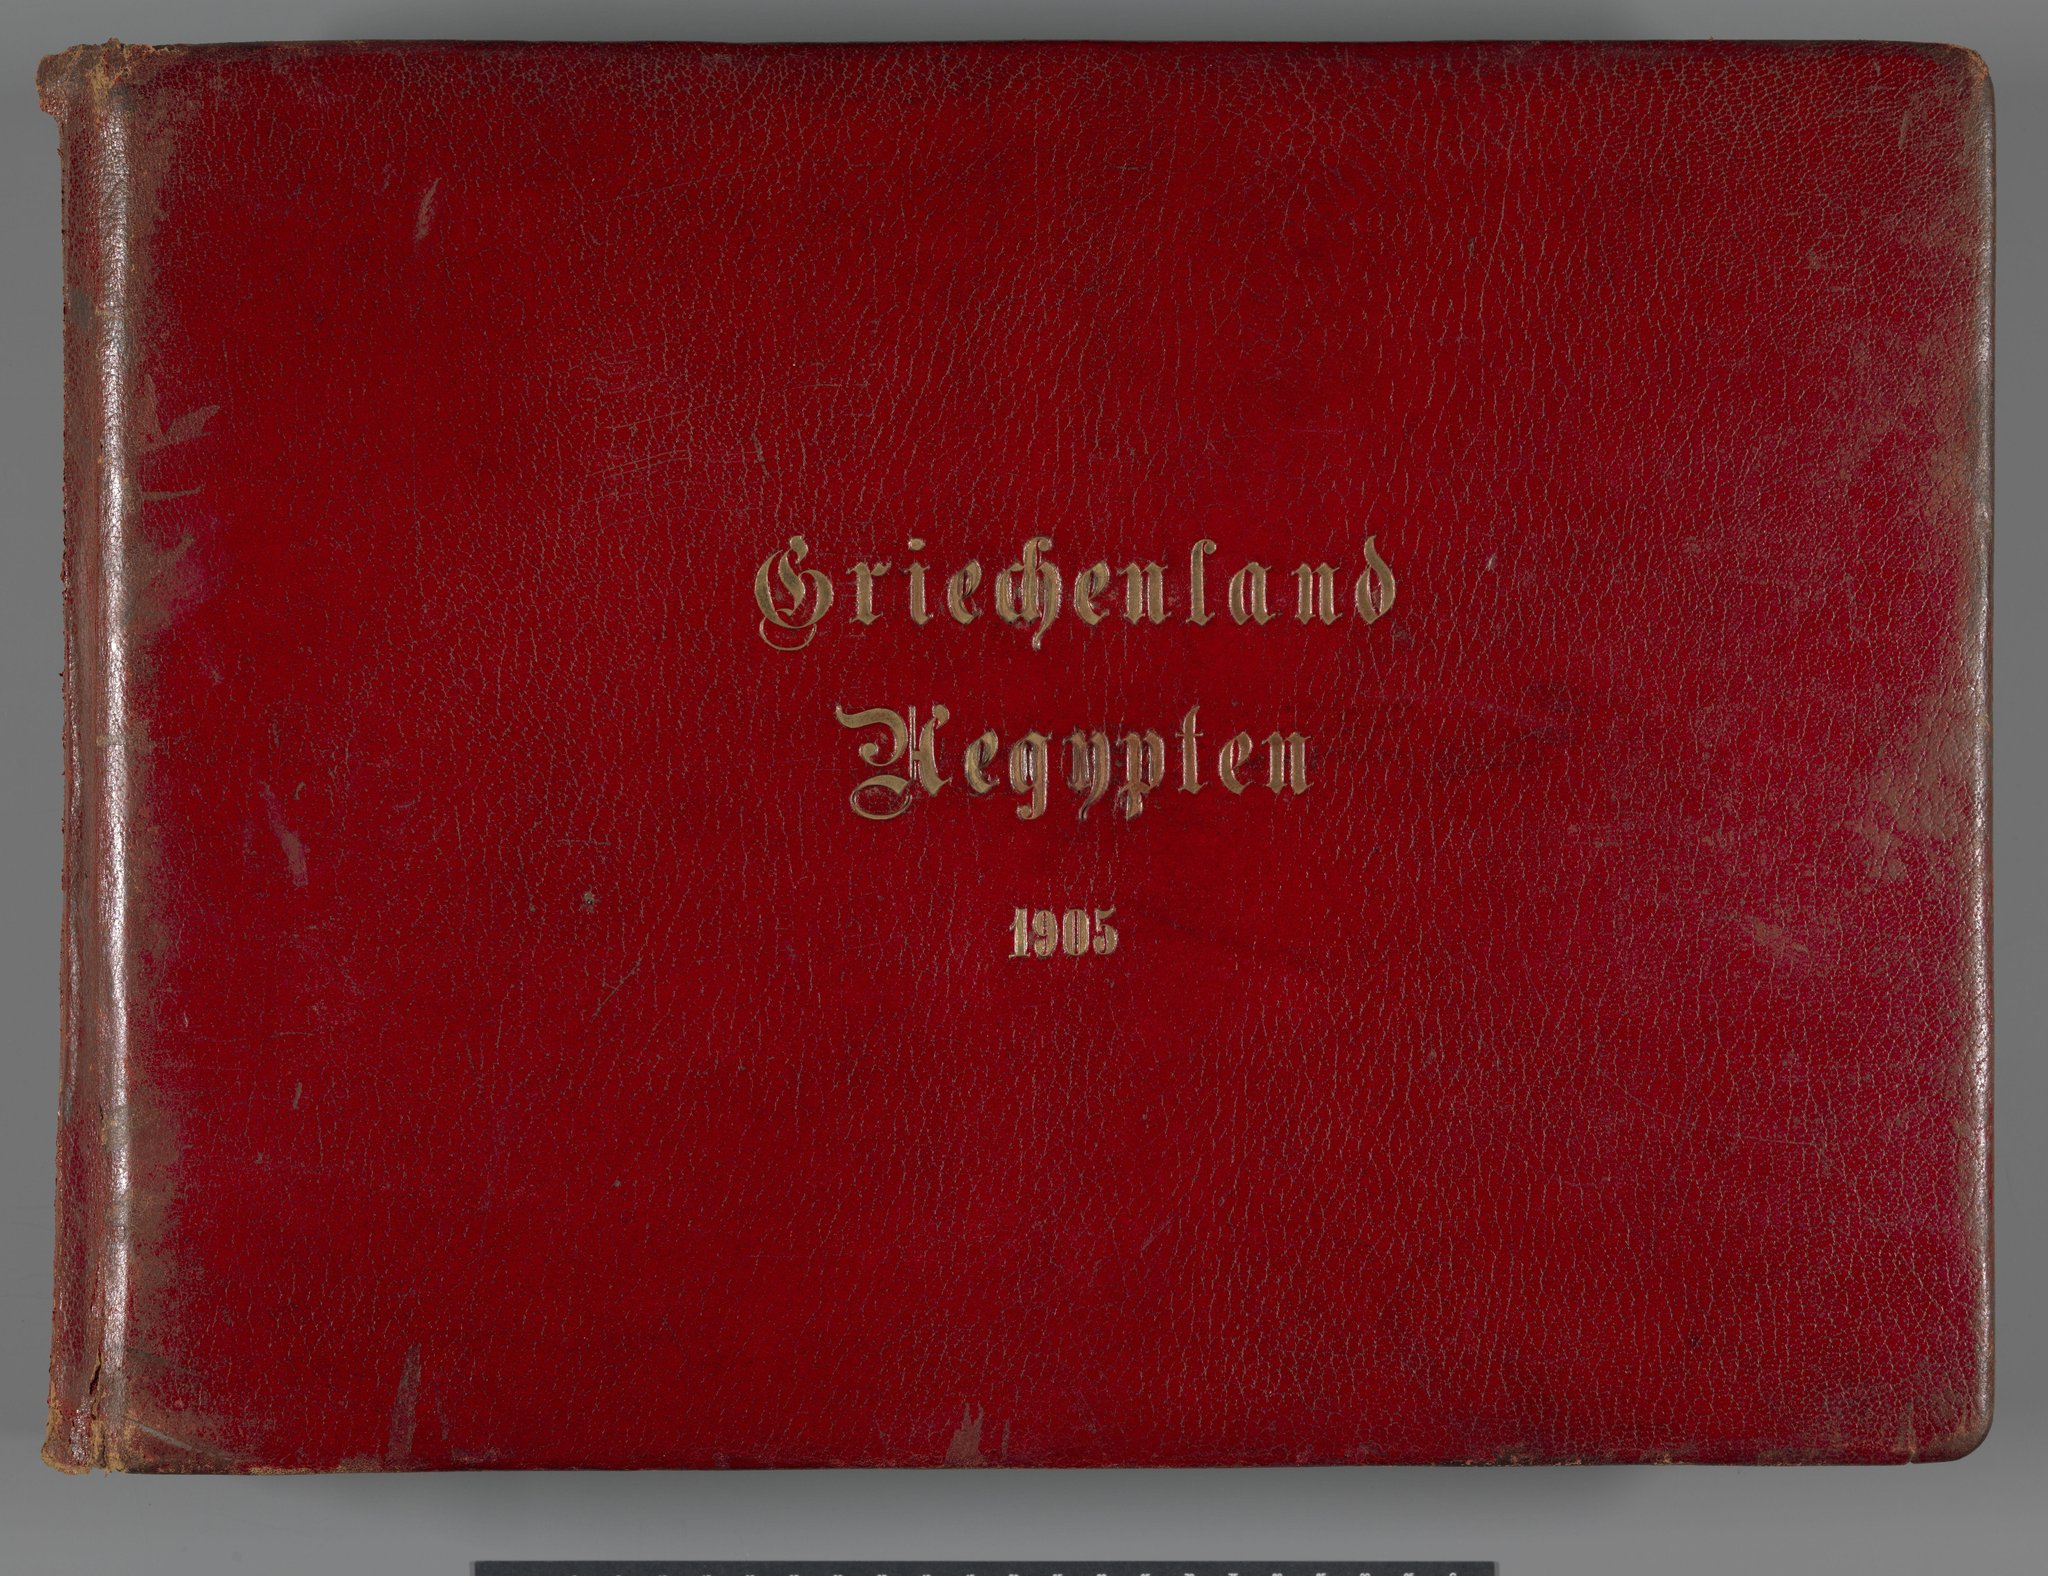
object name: scrapbook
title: Reisalbum met foto's van bezienswaardigheden in Griekenland en Egypte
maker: Anonymous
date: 1905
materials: cardboard, leather, paper, photographic support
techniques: albumen print, photograph, gelatin silver print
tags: travelling; tourism, excavation ~ archaeology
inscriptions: inscription: ‘[...]es 1905’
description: Fotoalbum in rode leren band met op het voorplat het opschrift 'Griechenland Aegypten 1905' in gouddruk. De schutbladen hebben een bloemmotief. Het album bevat 42 bladen met 183 foto's en een plattegrond. Het zijn voornamelijk opnames van bezienswaardigheden in Griekenland en Egypte, zoals stadsgezichten, landschappen, huizen, paleizen, opgravingen en portretten van de lokale bevolking. Het Achilleion op Corfu komt vele malen aan bod. Ook amateuropnames van mannen op de S.M.S. Loreley varend bij Lefkás, waaronder de Duitse archeoloog Wilhelm Dörpfeld (1853-1940).